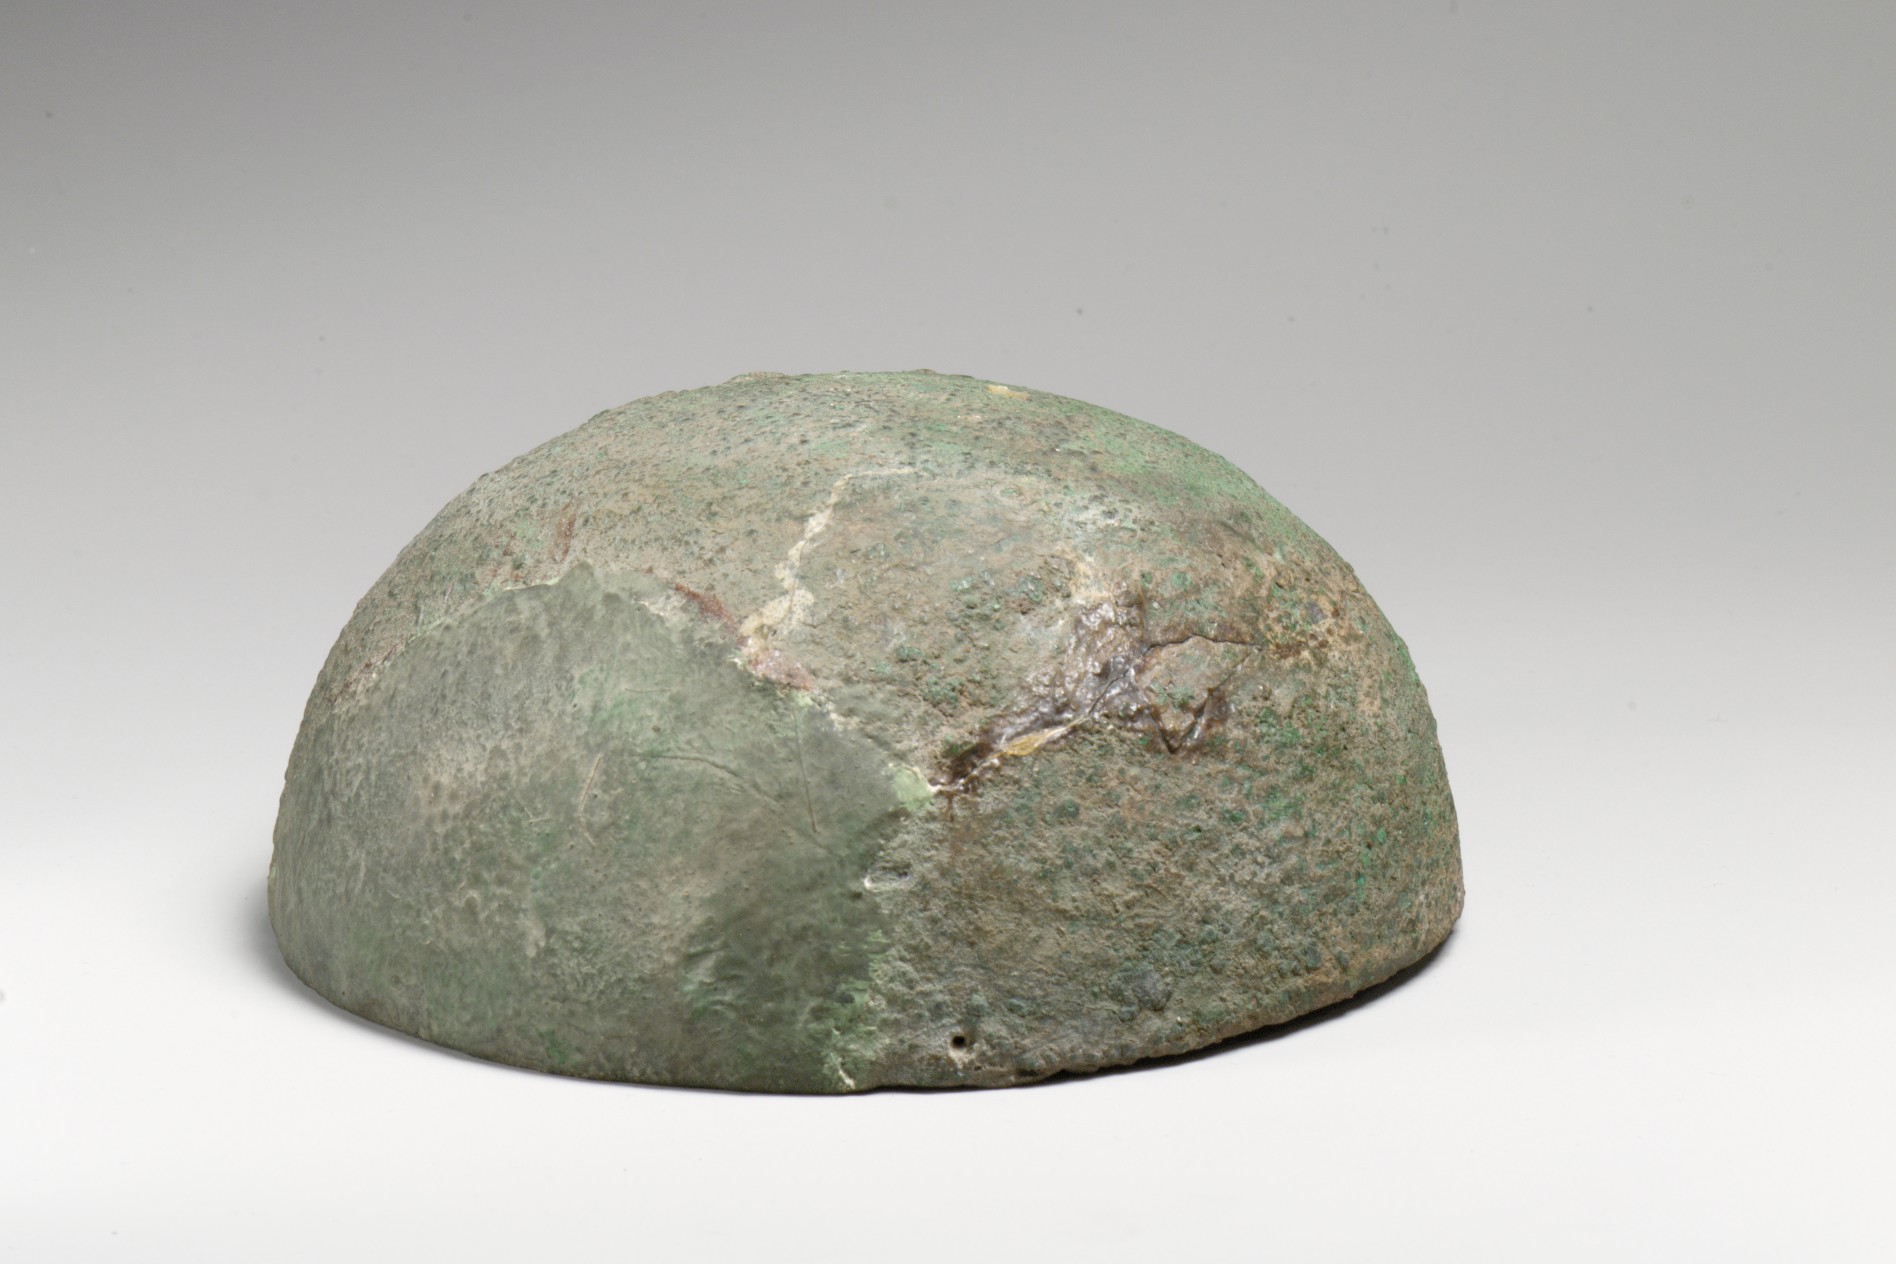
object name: bowl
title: Bronze hemispherical bowl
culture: cretan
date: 1100-901 BCE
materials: bronze